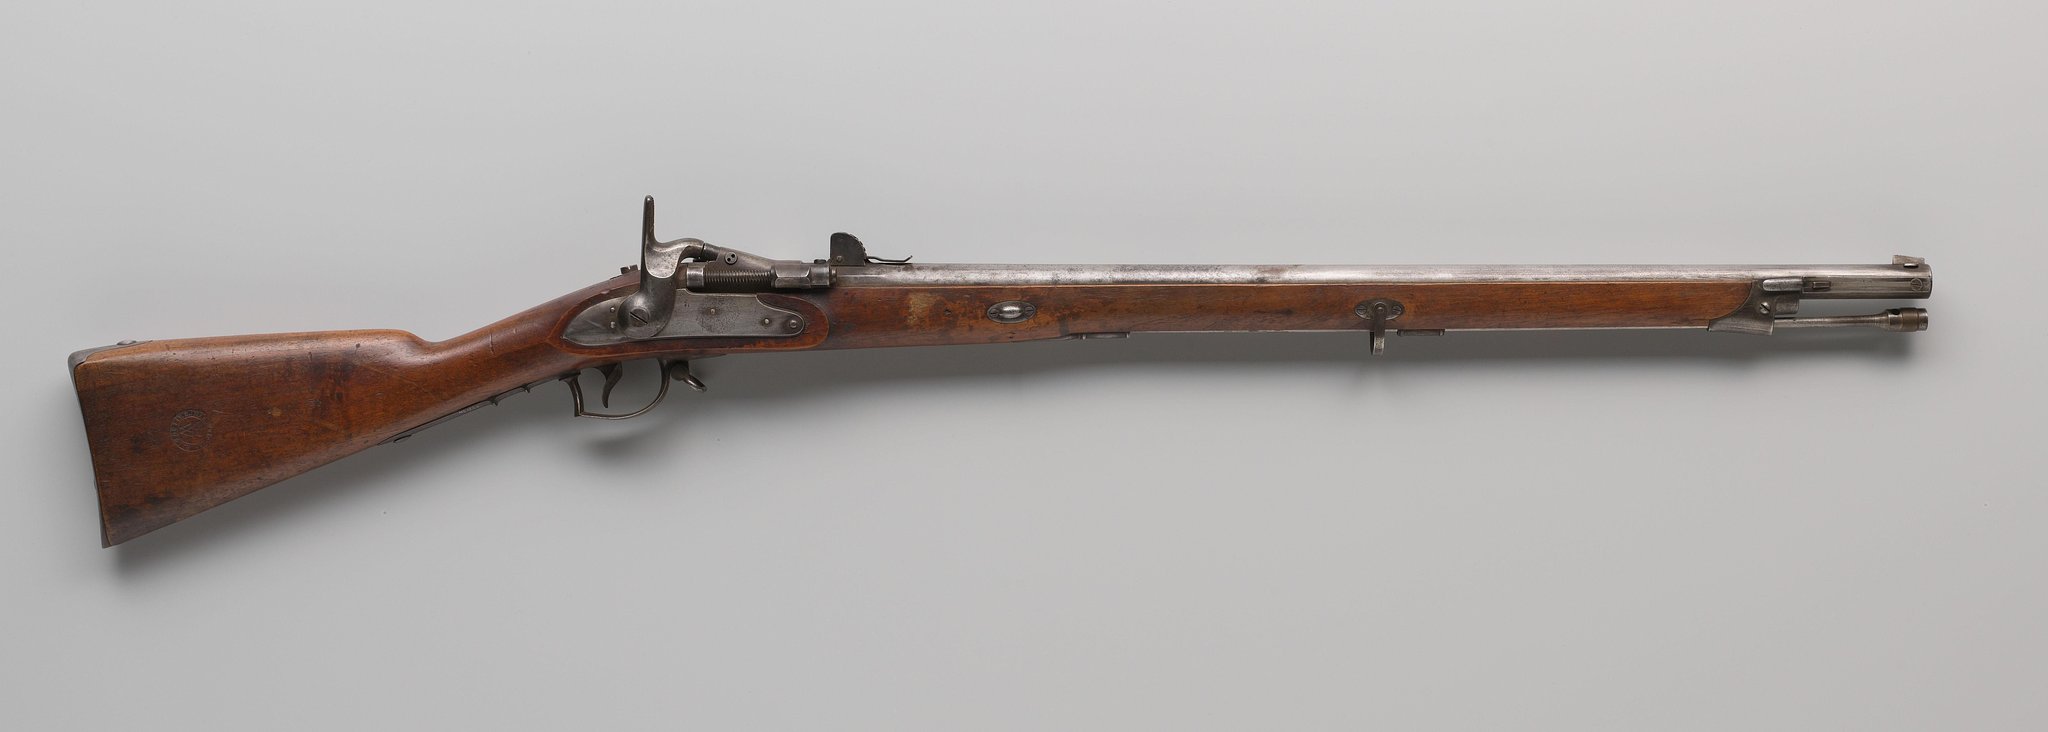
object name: centraalvuurgeweer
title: Breech-loading rifle, Snider system type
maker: p. stevens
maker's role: geweermaker, pistoolmaker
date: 1862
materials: bronze, iron, wood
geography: maastricht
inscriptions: inscription, on the gun: ‘P. STEVENS / MAASTRICHT P.S. MAASTRICHT N.B. / 1862 208’, inscription, on the bayonet: ‘S & K / 1861 // 208’, assayer's mark, on the rifle and the bayonet: various assayer’s marks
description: In 1851 zond P. Stevens uit Maastricht een model geweer aan de Marine; dit geweer is duidelijk later gedateerd. In 1867-1868 werden 70.000 geweren van het Nederlandse leger omgebouwd naar het Snider-systeem. Dit geweer is een getransformeerd tirailleurgeweer. Op grond van de afmetingen van de lade moet het oorspronkelijke geweer een percussiegeweer No. 1 van 1848 geweest zijn, maar de loop is korter.